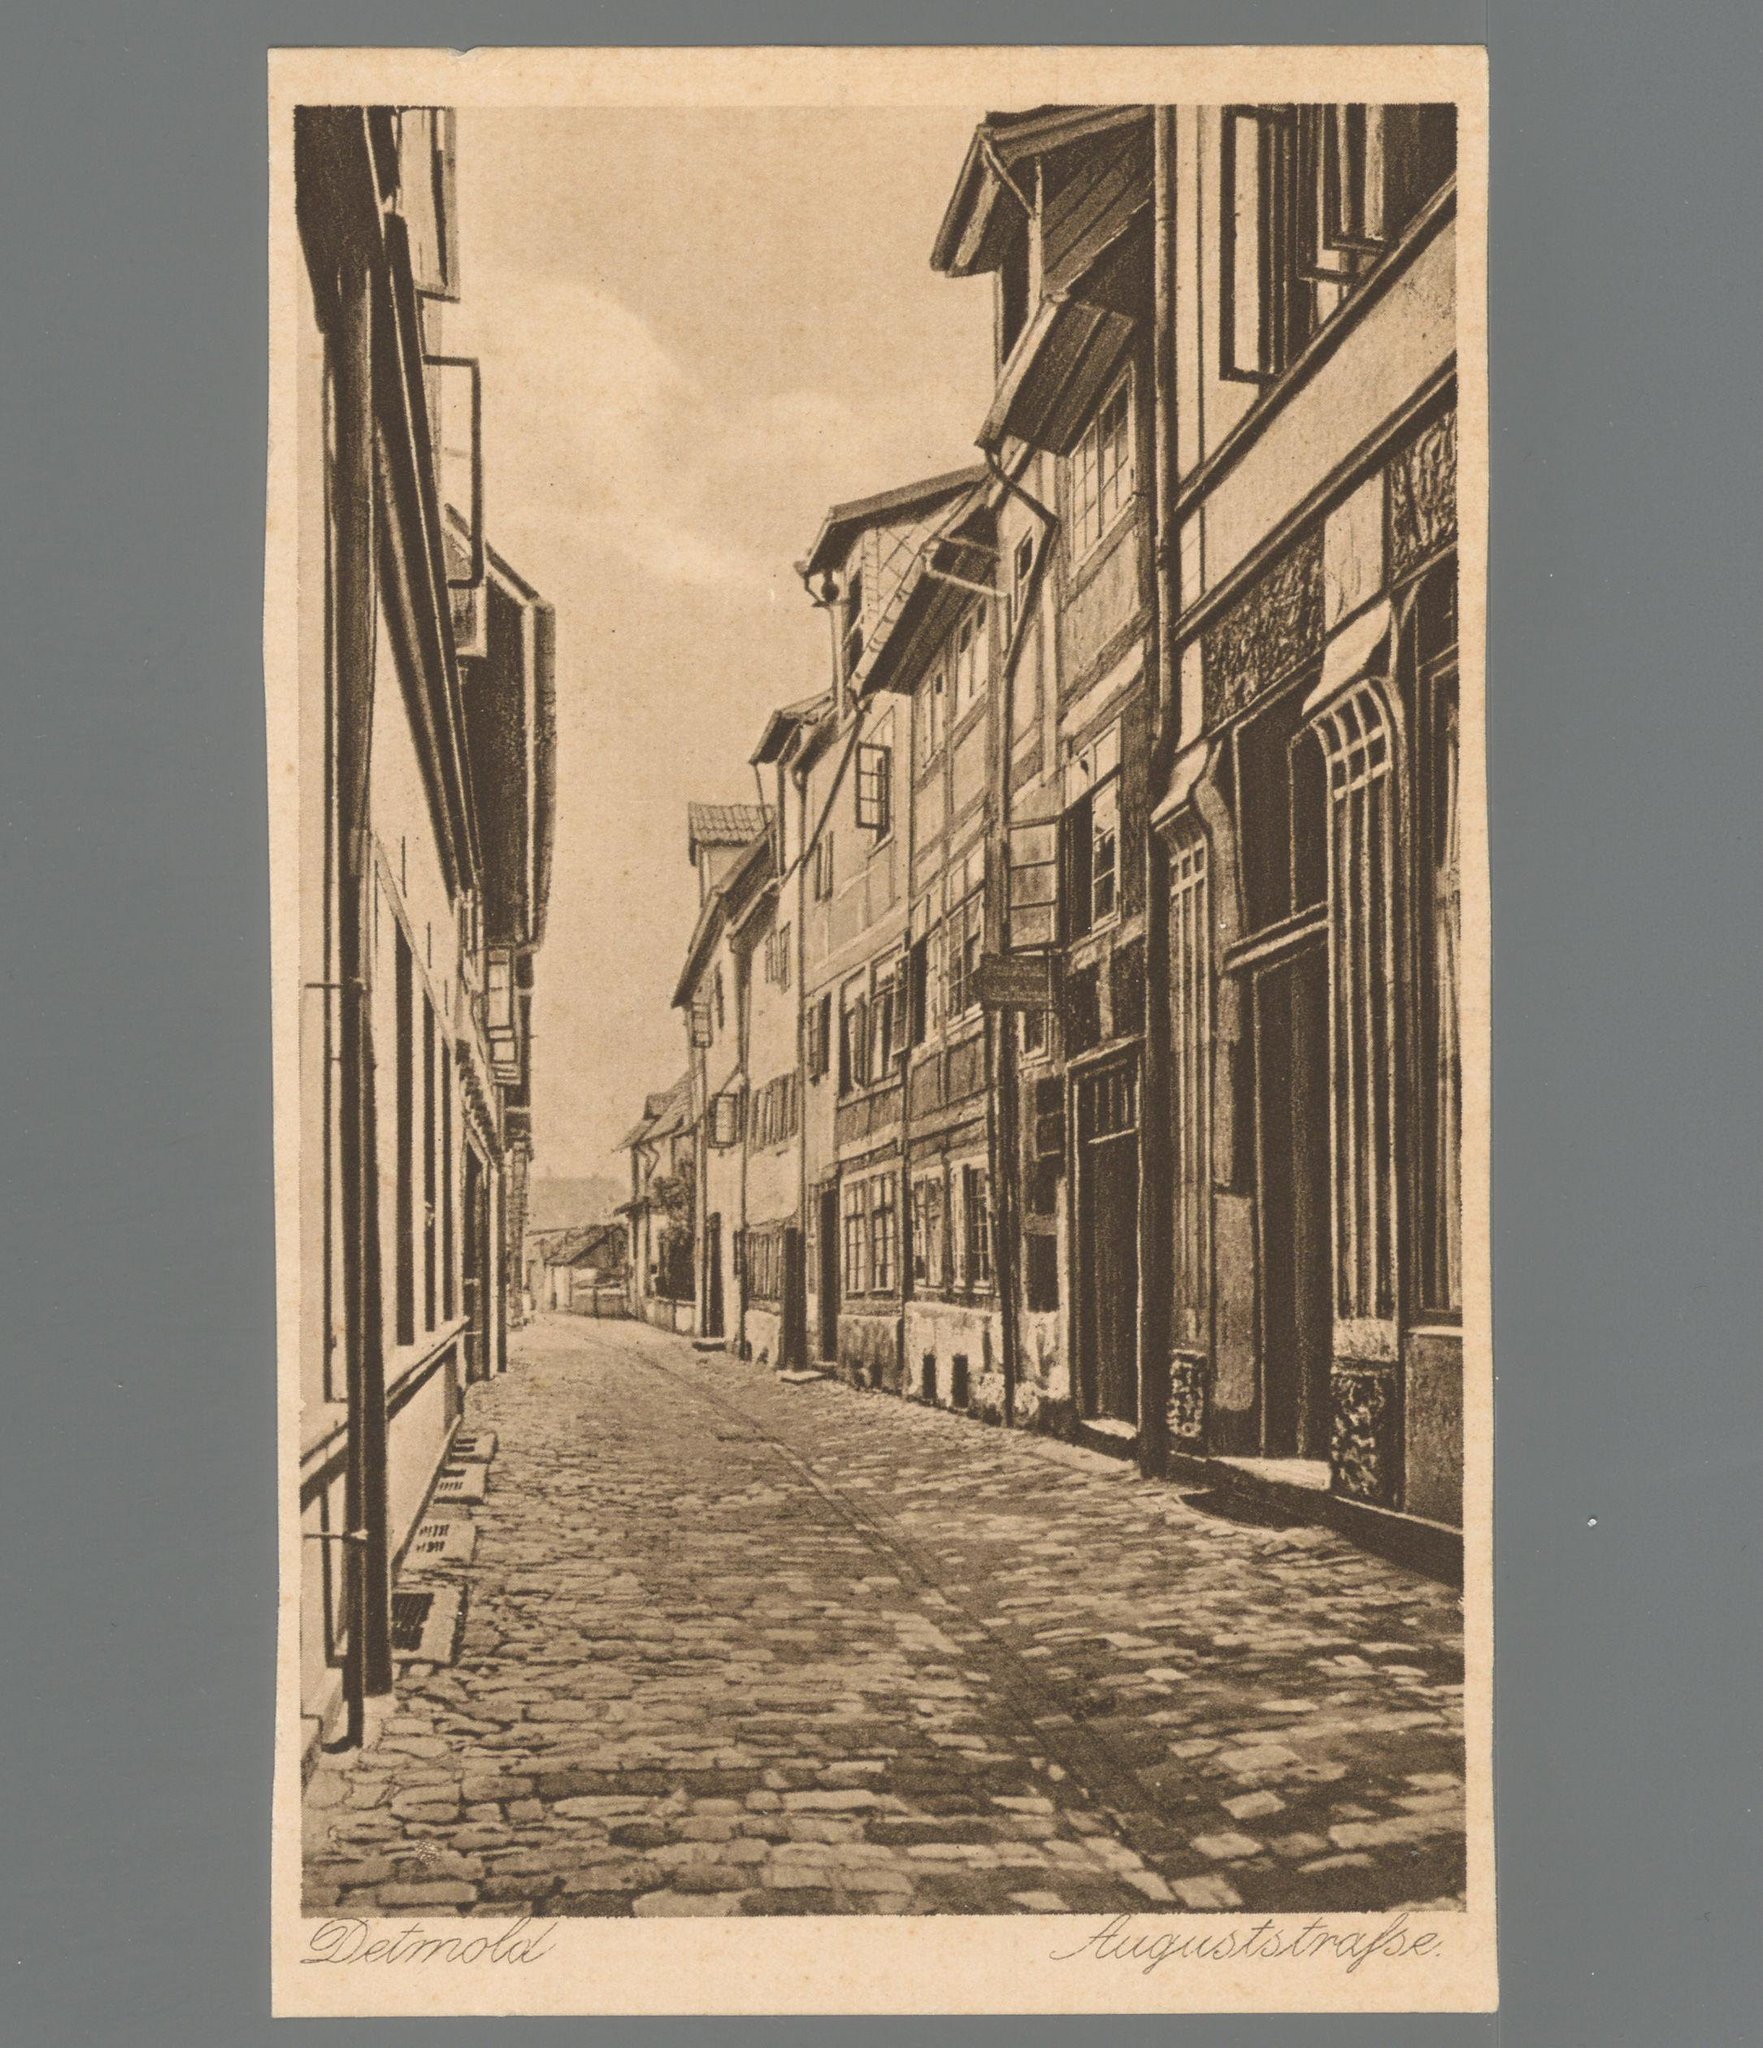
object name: ansichtkaart, prentbriefkaart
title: Detmold. Auguststrasse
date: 1905-1930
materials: cardboard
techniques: rotogravure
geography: kassel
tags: street